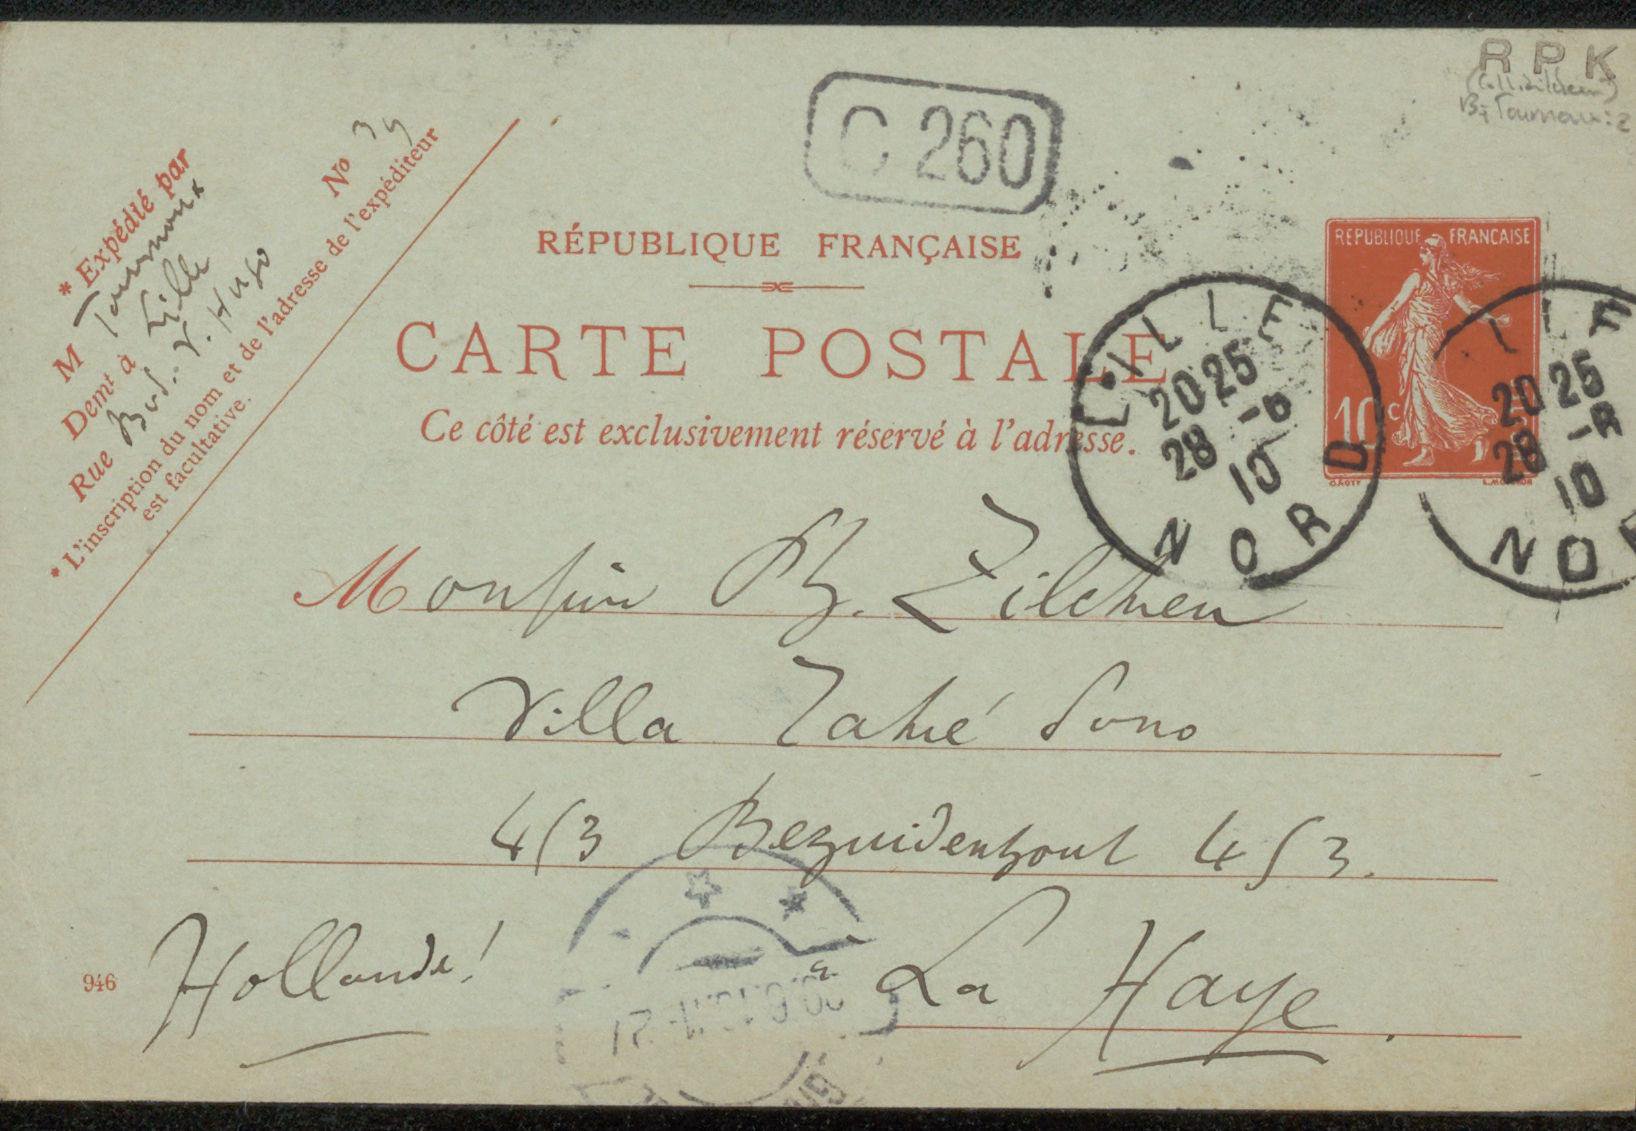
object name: postcard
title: Briefkaart aan Philip Zilcken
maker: georges a. tournoux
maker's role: professor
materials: cardboard, ink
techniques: pen, writing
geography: lille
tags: paris, paul verlaine, painter, draughtsman, philip zilcken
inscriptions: collector's mark: ‘RPK’